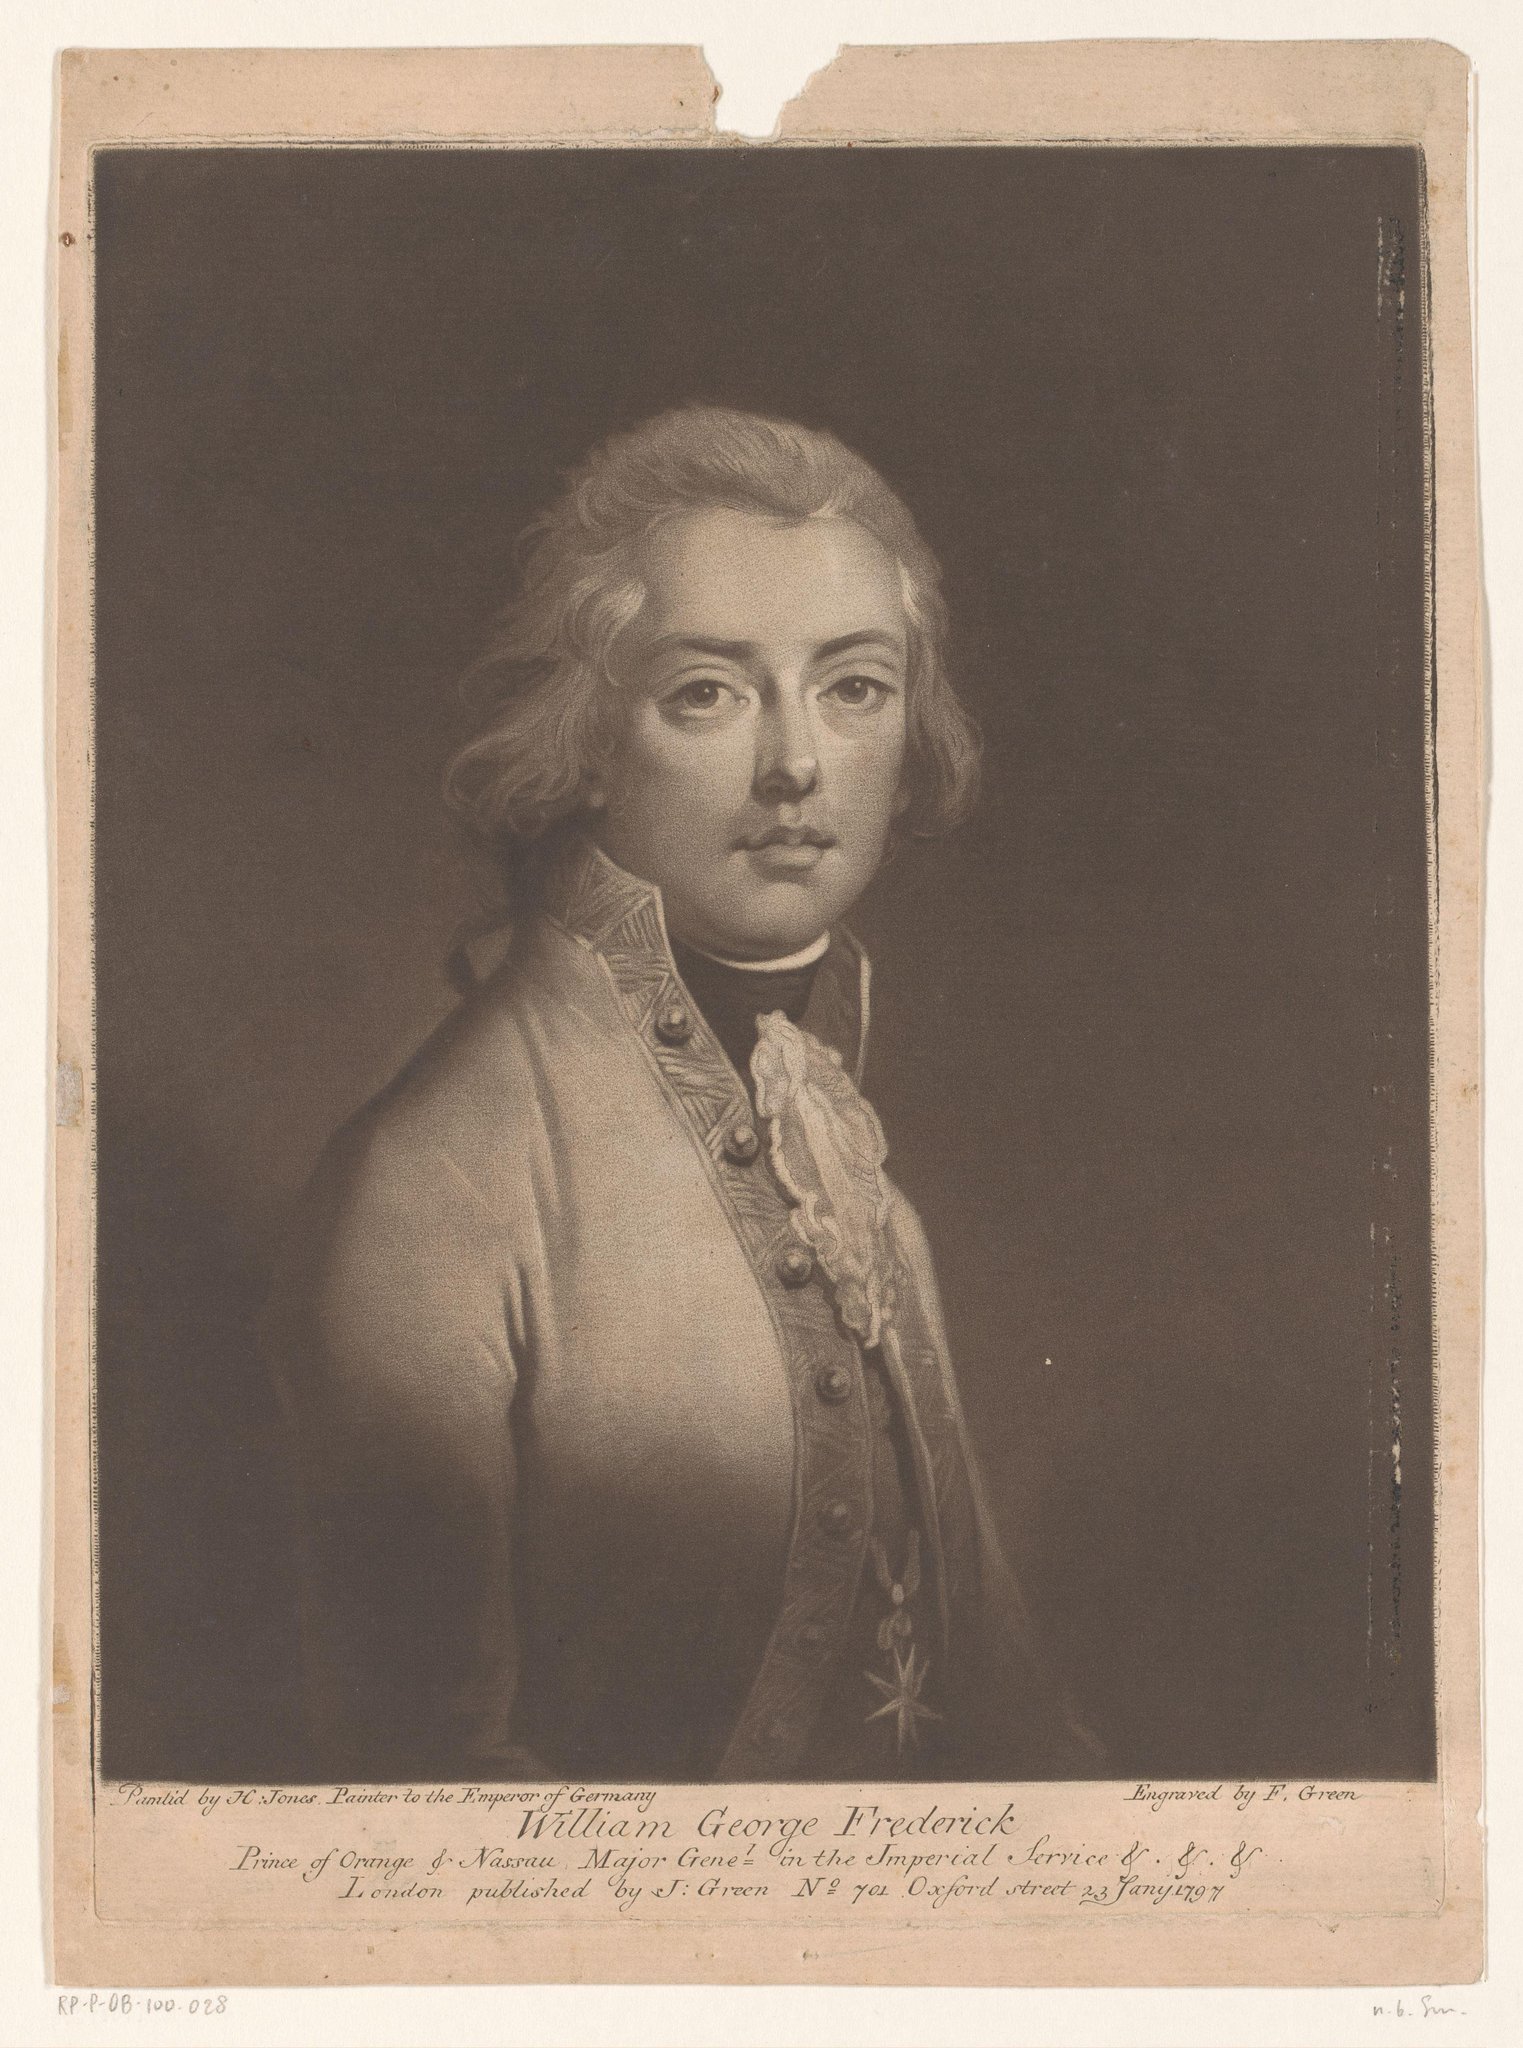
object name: print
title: Portret van Willem George Frederik van Oranje-Nassau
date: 1797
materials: paper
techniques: mezzotint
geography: london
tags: the hague, willem george frederik (prins van oranje-nassau), prince, historical persons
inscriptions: collector's mark: Lugt 2228